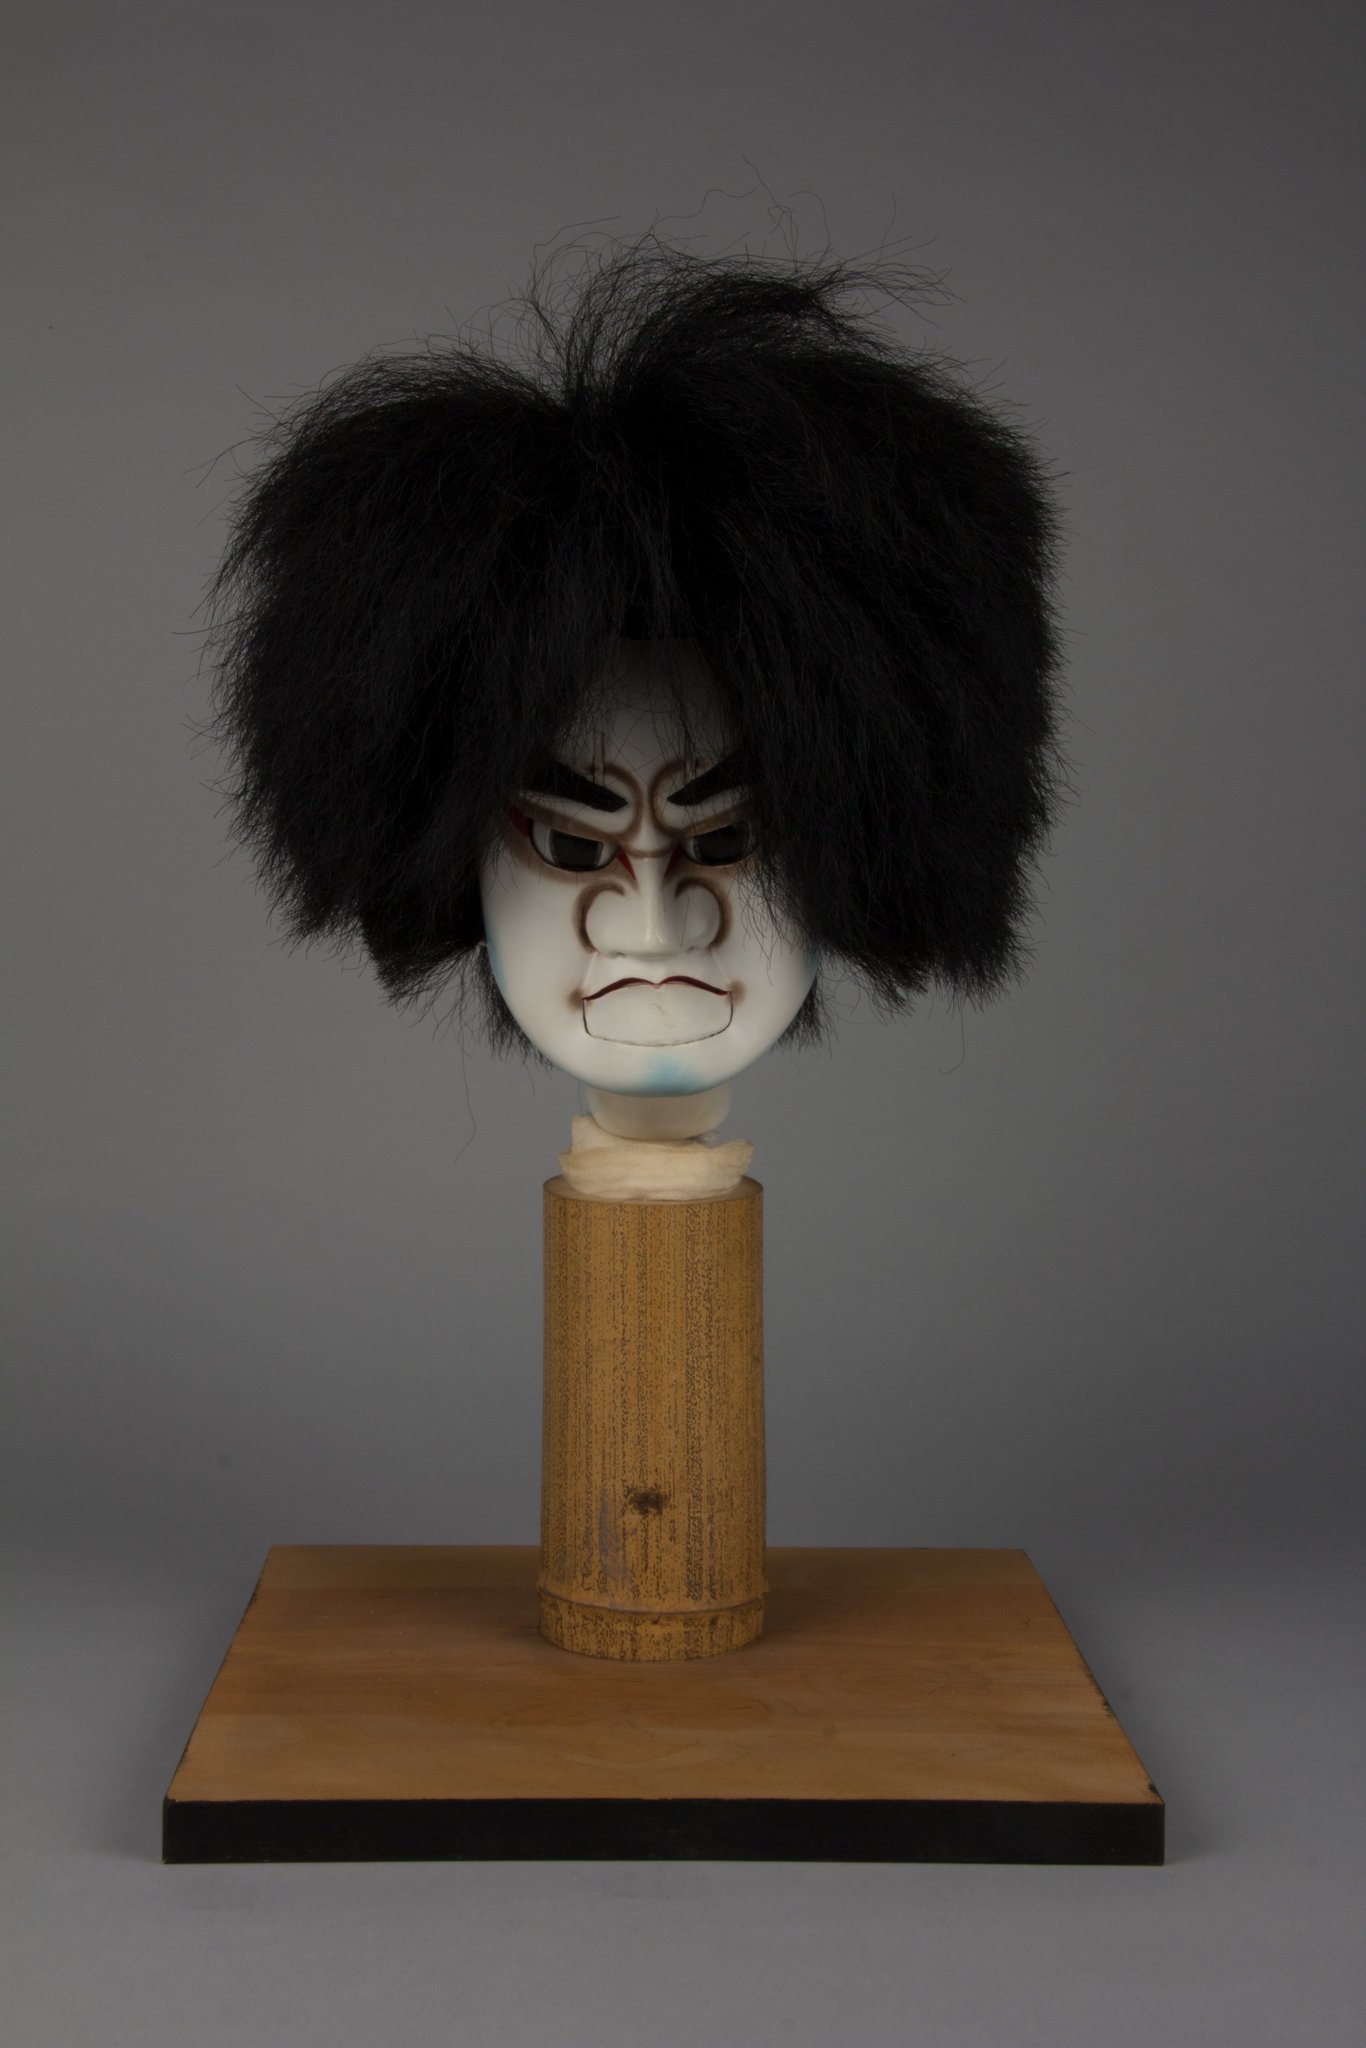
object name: puppet head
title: Bunraku Puppet Head for Young Male Role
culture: japanese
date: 1801-1900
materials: wood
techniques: painting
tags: hair,heads,men